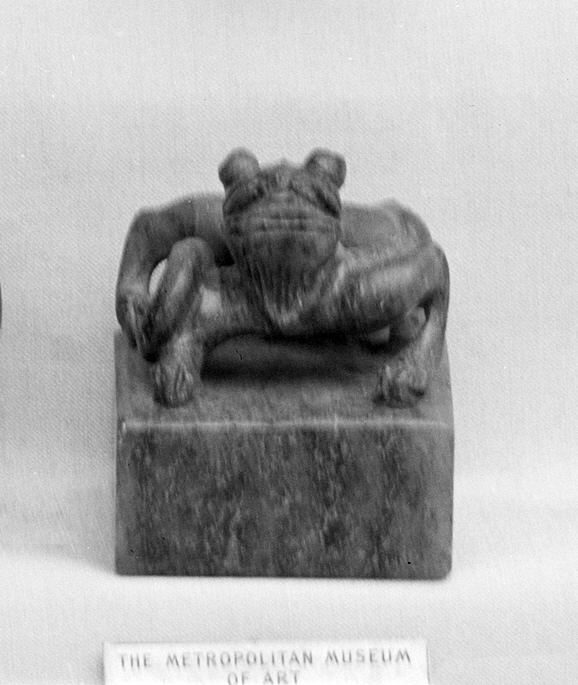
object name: seal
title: Seal with Crouching Dragon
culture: chinese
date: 206 BCE-220 CE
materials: jade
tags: dragons